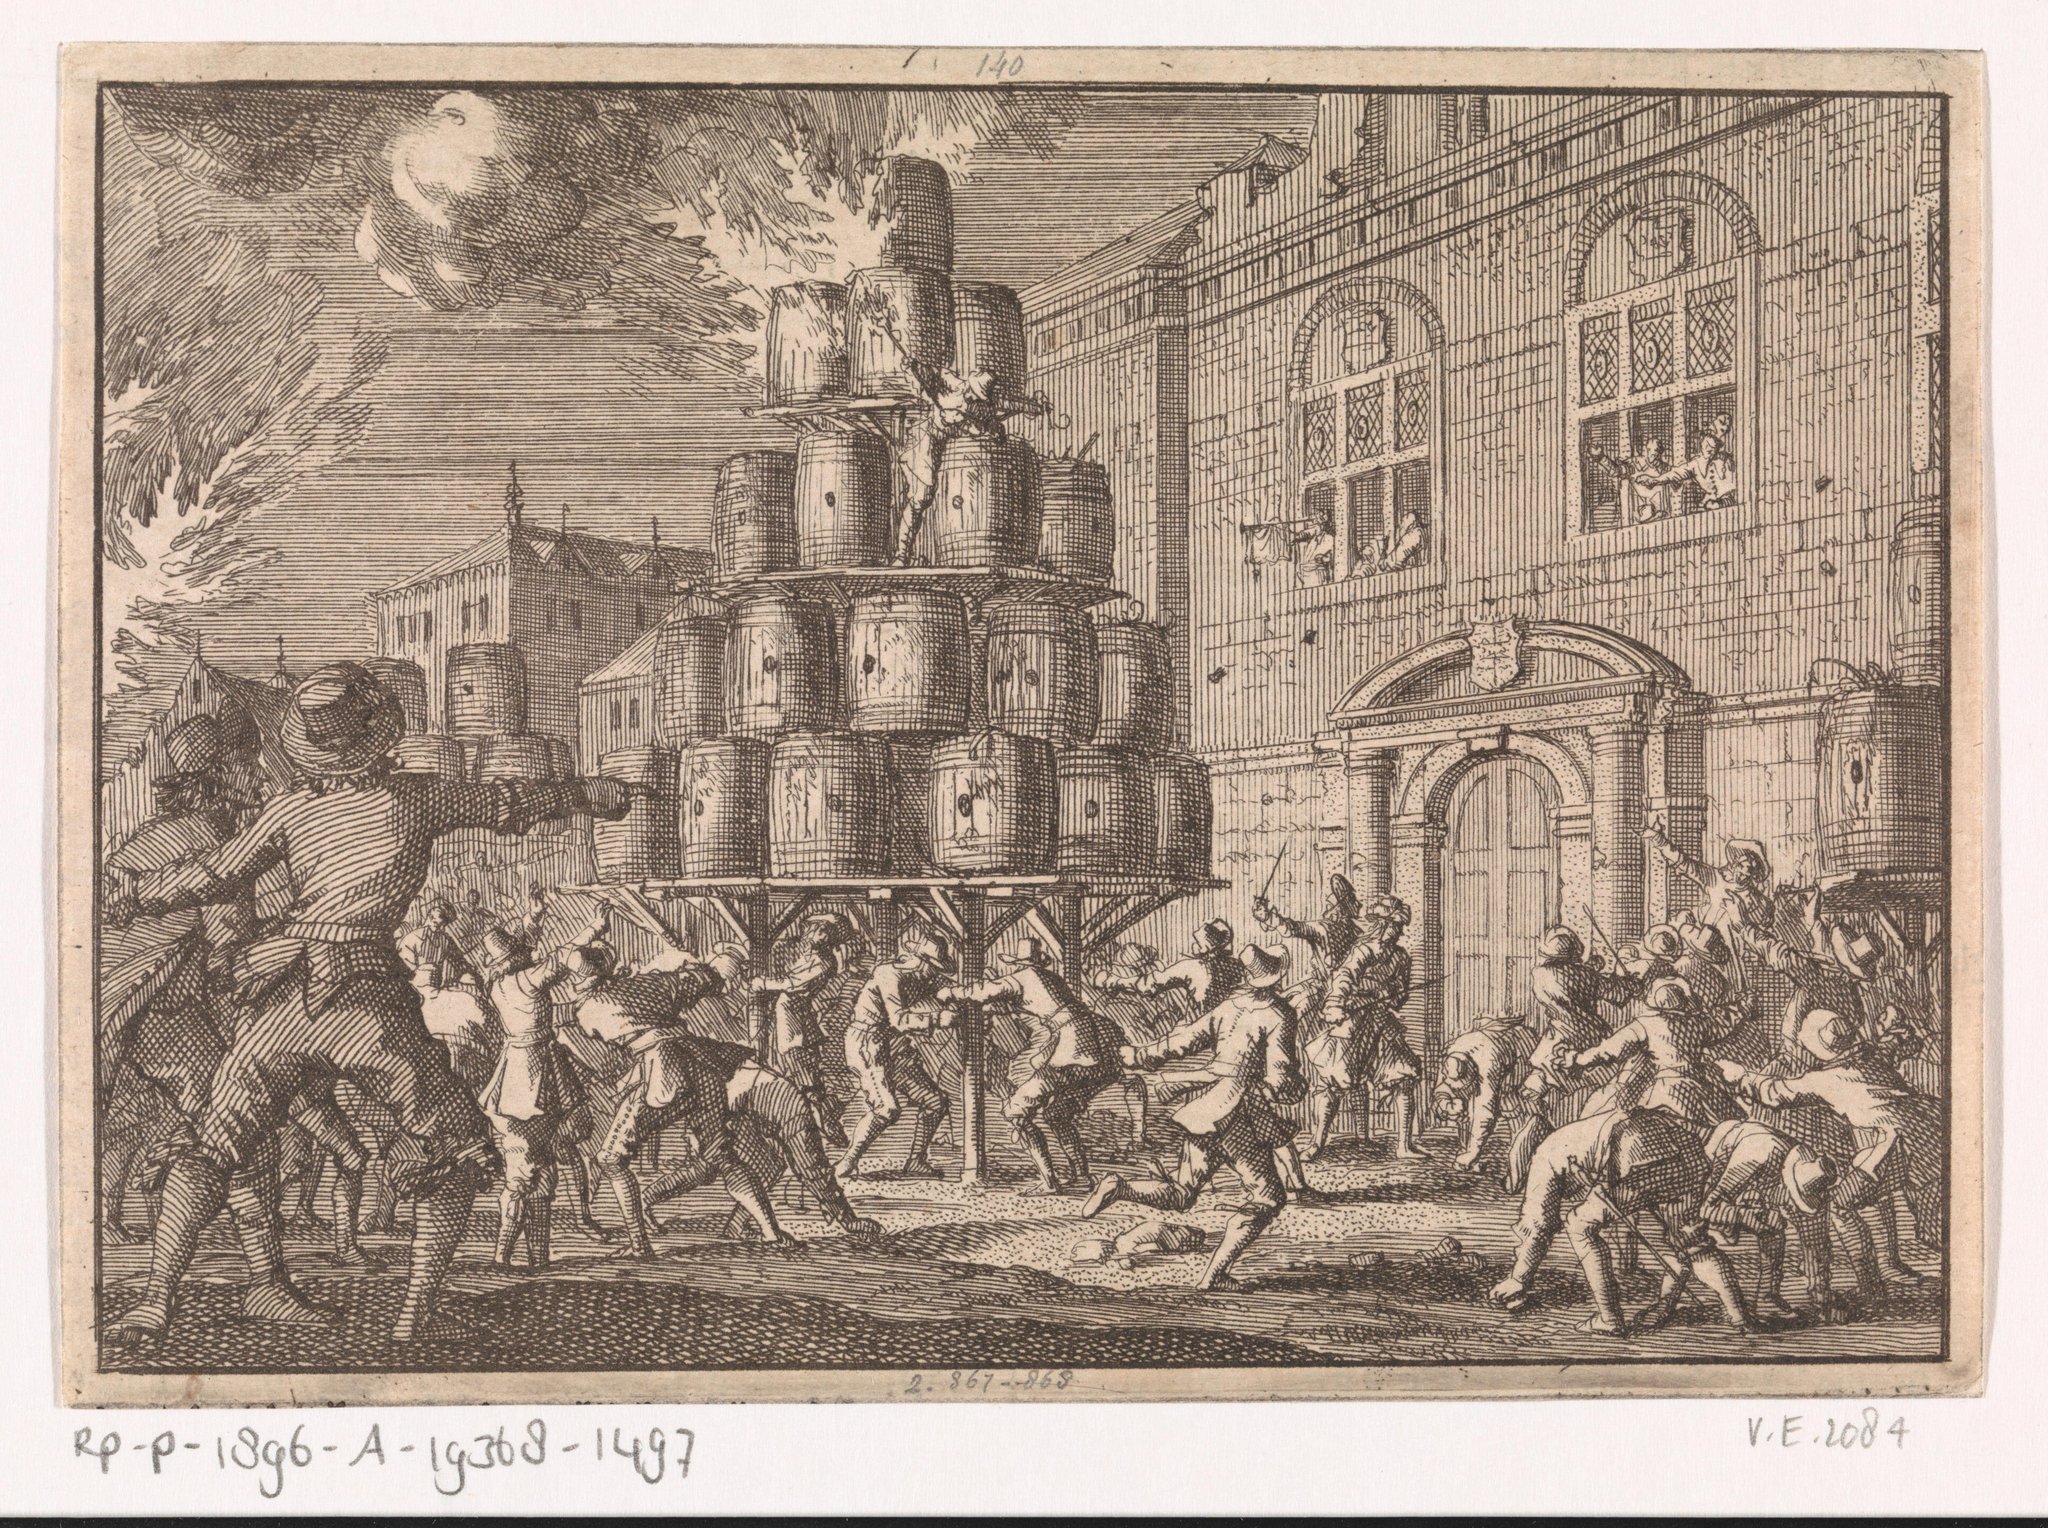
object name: print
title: Het volk van Brussel belet de ontsteking van een vreugdevuur opgericht ter ere van de overwinning op de Engelsen in de Vierdaagse Zeeslag, 1666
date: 1698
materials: paper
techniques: etching, letterpress printing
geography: leiden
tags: rescue from fire, rejoicing on special occasions, brussels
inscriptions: collector's mark: Lugt 2228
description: Illustratie uit: Gottfried, Johann Ludwig. Historische kronyck; vervattende een (...) beschrijvingh der aldergedenckwaerdigste geschiedenissen des weerelds, van den aenvangh der scheppingh tot (...) 1576 (2 delen). Leiden: Pieter van der Aa, 1698, dl. II, p. 867.